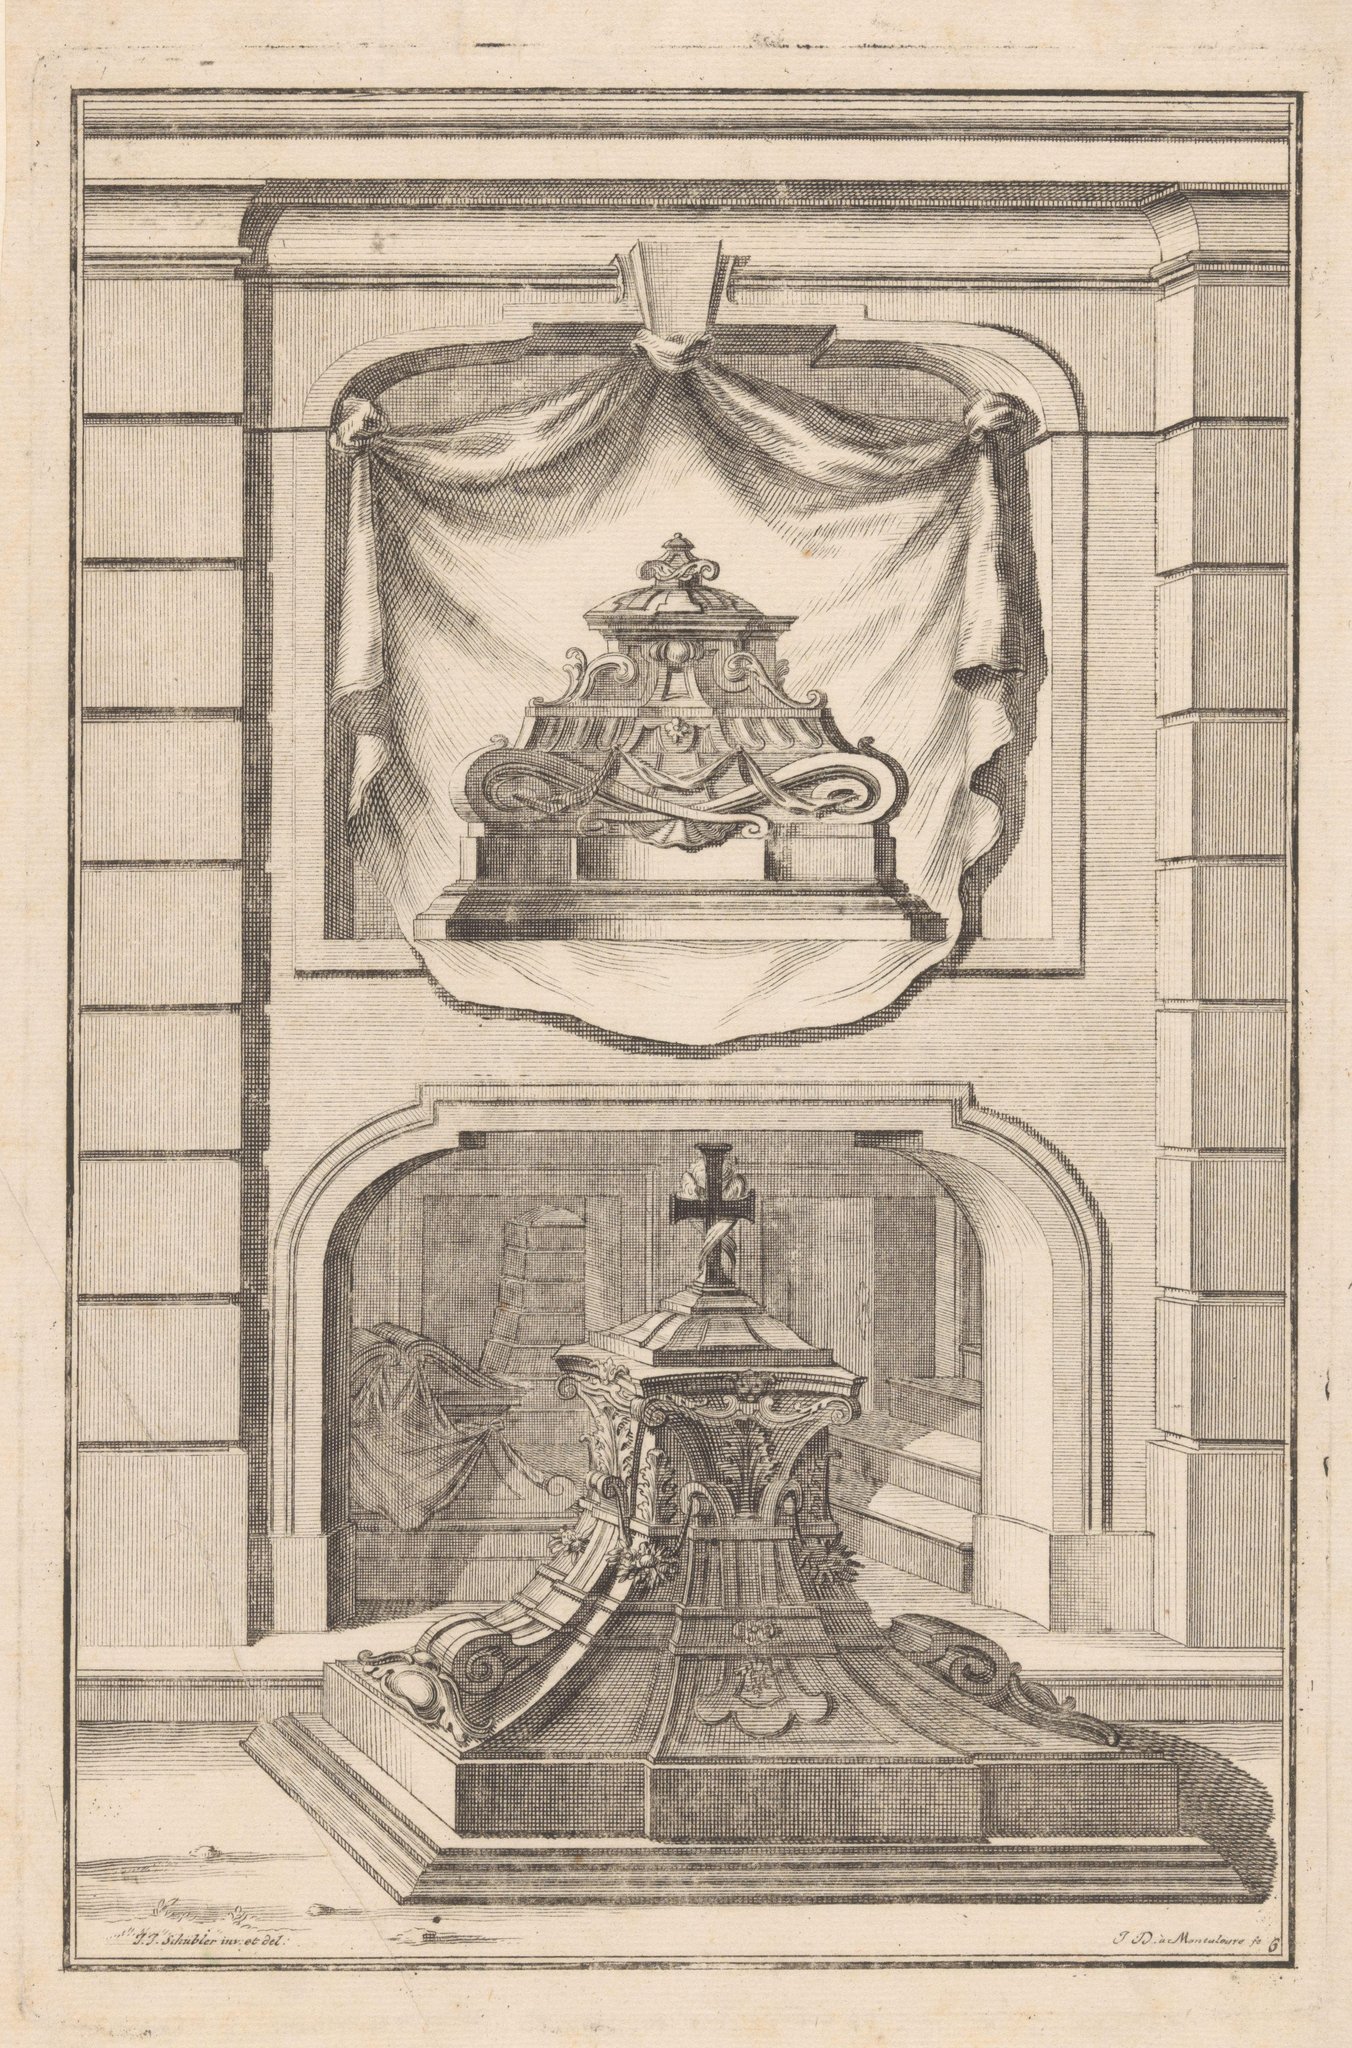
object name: ornament print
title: Representation d'Orthographie de diverses sortes d'Epitaphes (...)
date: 1707-1726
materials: paper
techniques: engraving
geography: nuremberg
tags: niche-tomb, wall-tomb, grave, tomb, hangings and drapery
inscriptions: collector's mark: Lugt 2760, collector's mark: Lugt 2228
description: Een geornamenteerde tombe bekroond met een kruis staat voor een muur met een doorgang naar een volgende ruimte met tombes. Boven de doorgang bevindt zich een andere geornamenteerde tombe in een nis met draperie.